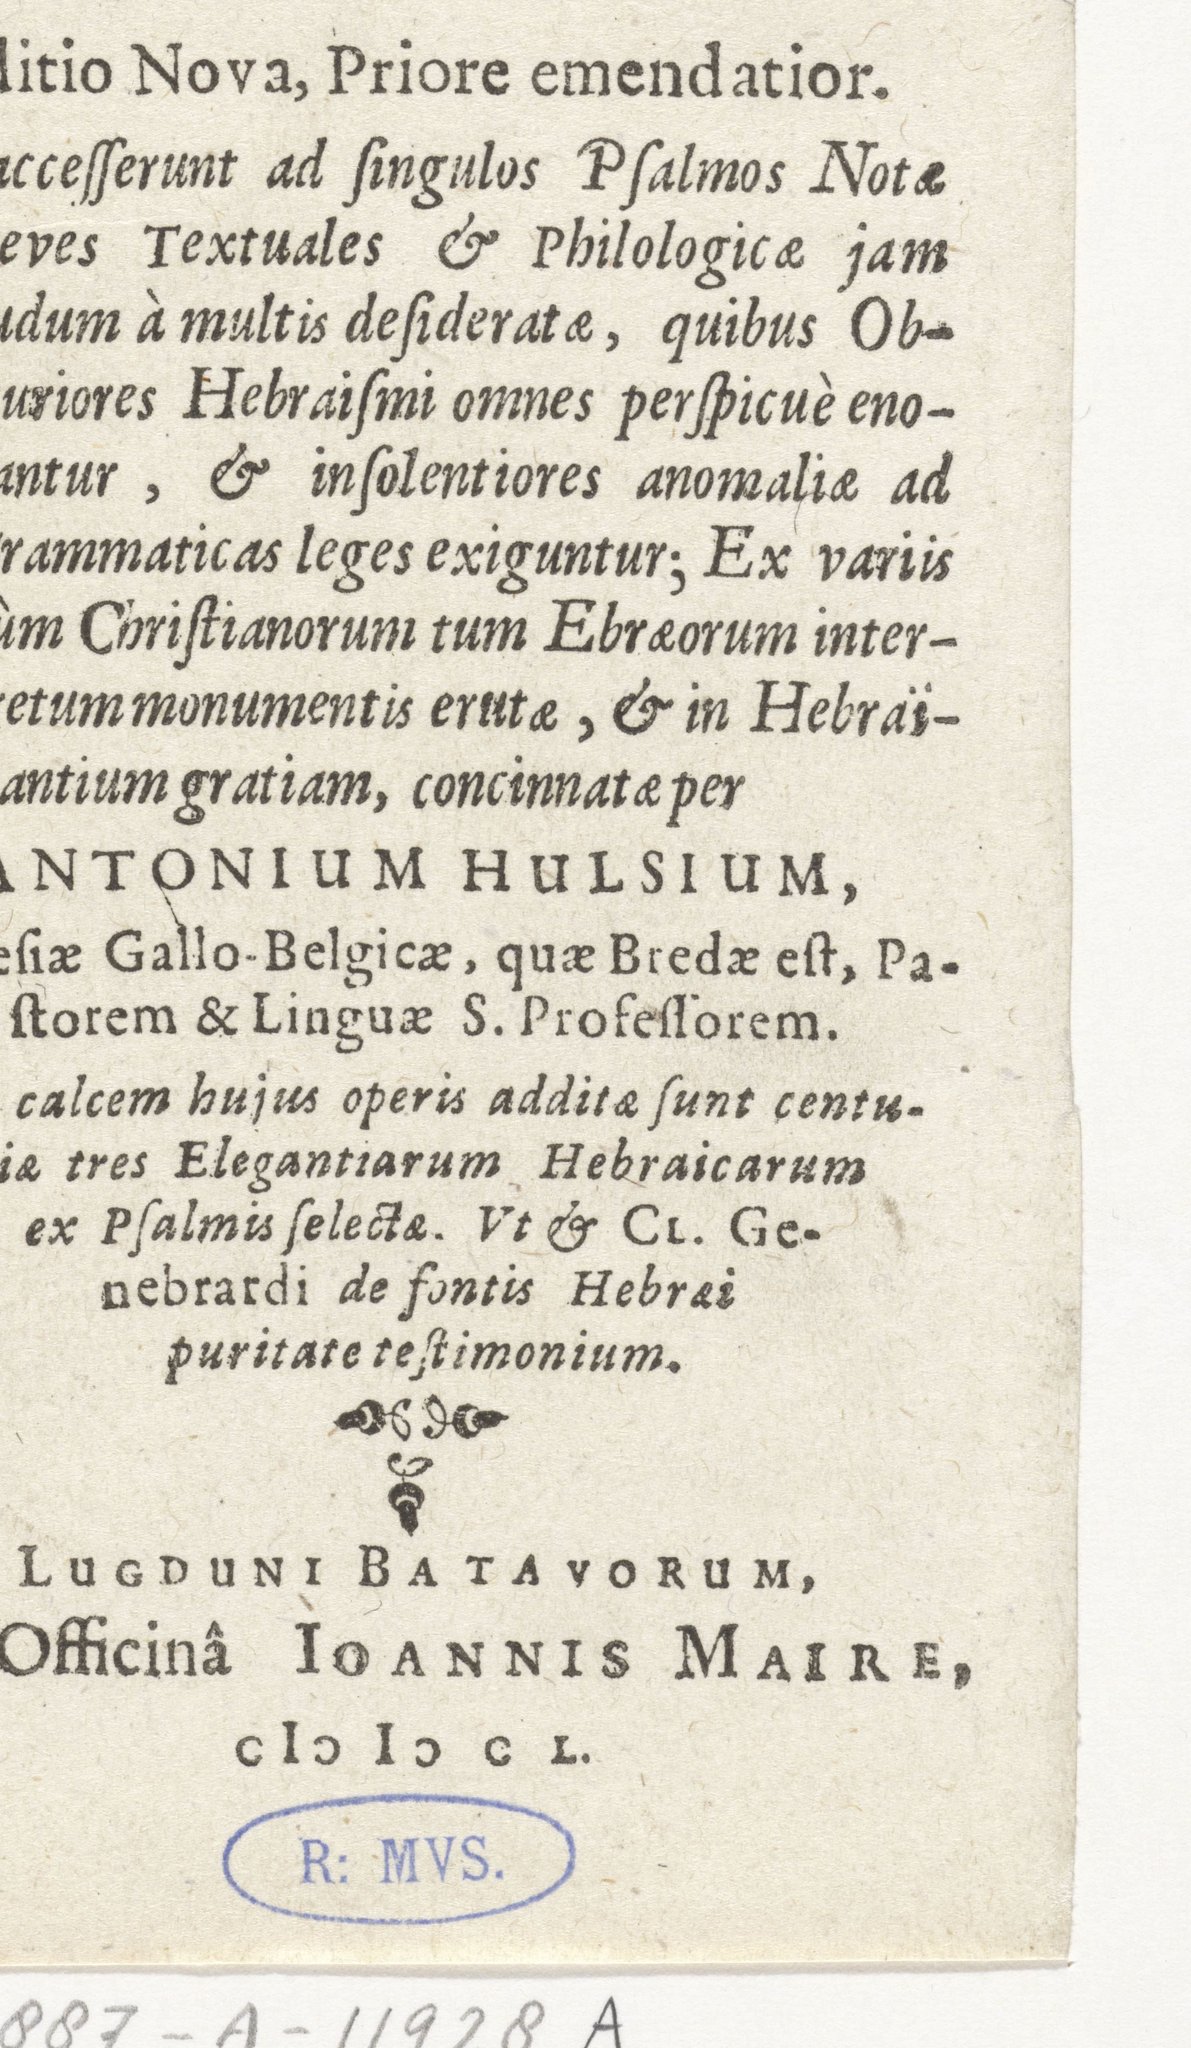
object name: text sheet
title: Titelpagina voor: Hulsius, Antonius. Liber psalmorum Hebraicè, Leiden: Joannes Maire, 1650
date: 1650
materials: paper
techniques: letterpress printing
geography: leiden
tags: floral interlace ~ ornament, title-page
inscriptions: collector's mark: Lugt 2228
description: Titelpagina voor: Hulsius, Antonius. Liber psalmorum Hebraicè, Leiden: Joannes Maire, 1650. Deze titelpagina werd in dezelfde uitgave afgedrukt als RP-P-1887-A-11928. Bron: WorldCat.